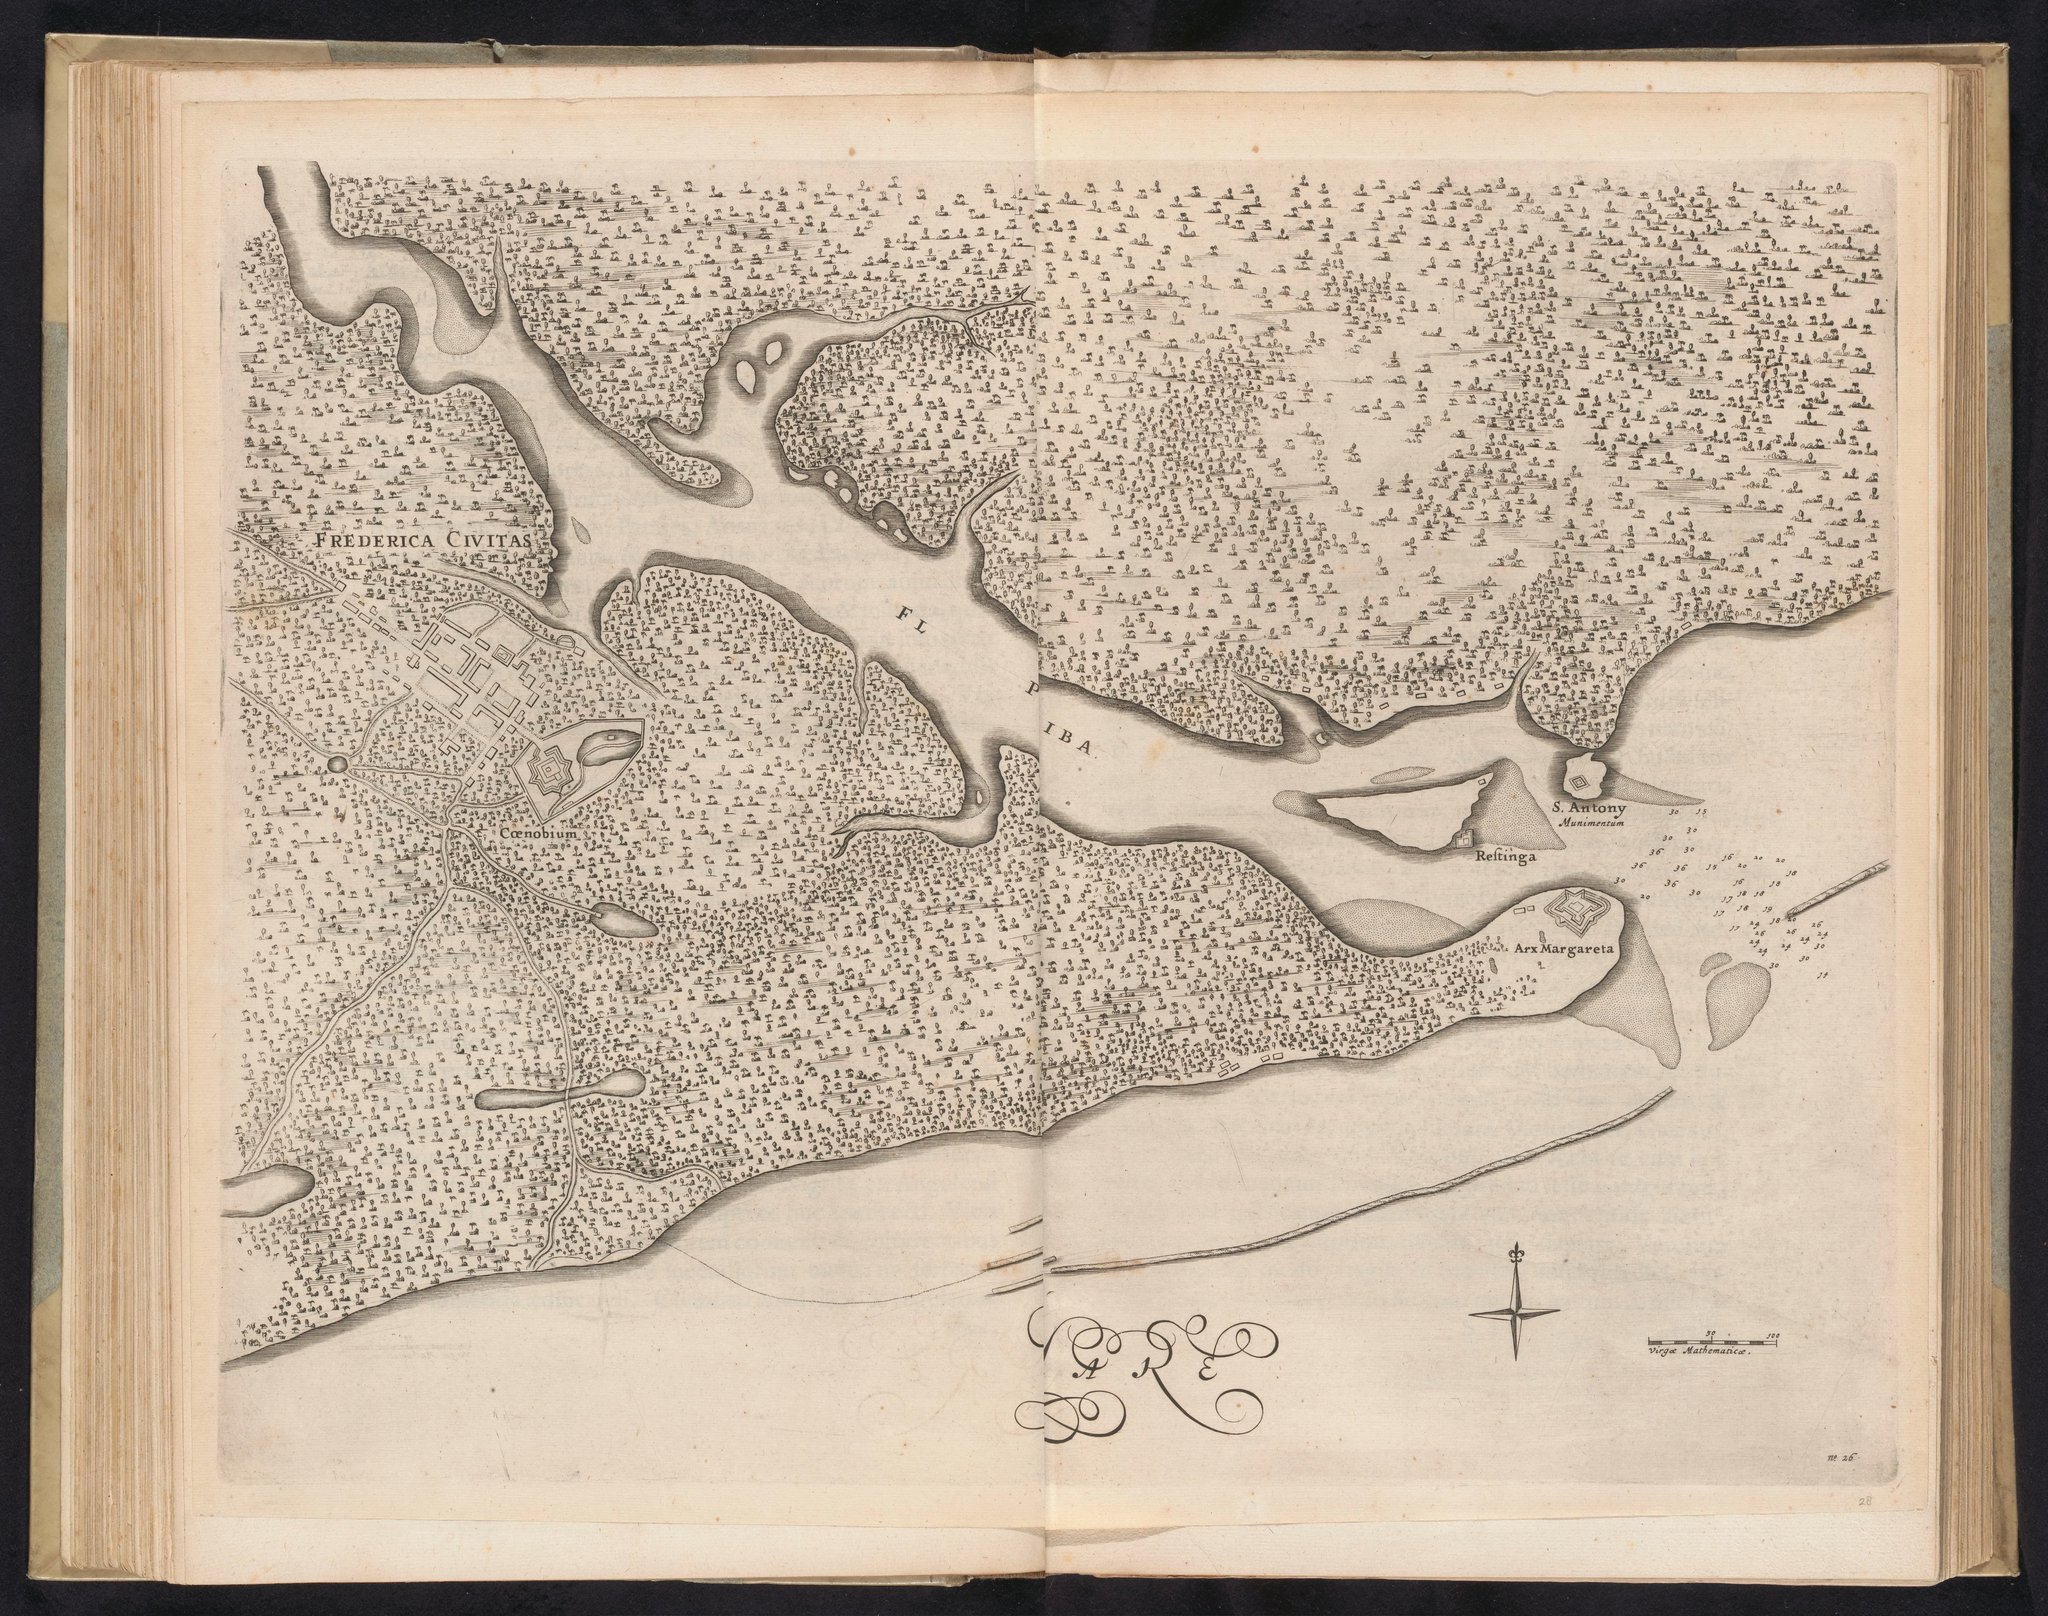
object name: map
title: Kaart met de forten aan de monding van de rivier Paraiba, ca. 1636-1644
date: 1645-1647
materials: paper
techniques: engraving, etching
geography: amsterdam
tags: earl, johan maurits graaf van nassau-siegen, fortress, maps of cities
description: Illustratie in: Caspar Barlaeus, Rerum per octennium in Brasilia et alibi nuper gestarum sub praefectura J. Mauritii, Nassoviae, c. comitis... historia, Joannes Blaeu, Amsterdam 1647, plaat nr. 26, p. 70/71. Prent in het exemplaar in de collectie van de Rijksmuseum Research Library, standplaats 330 A 18.